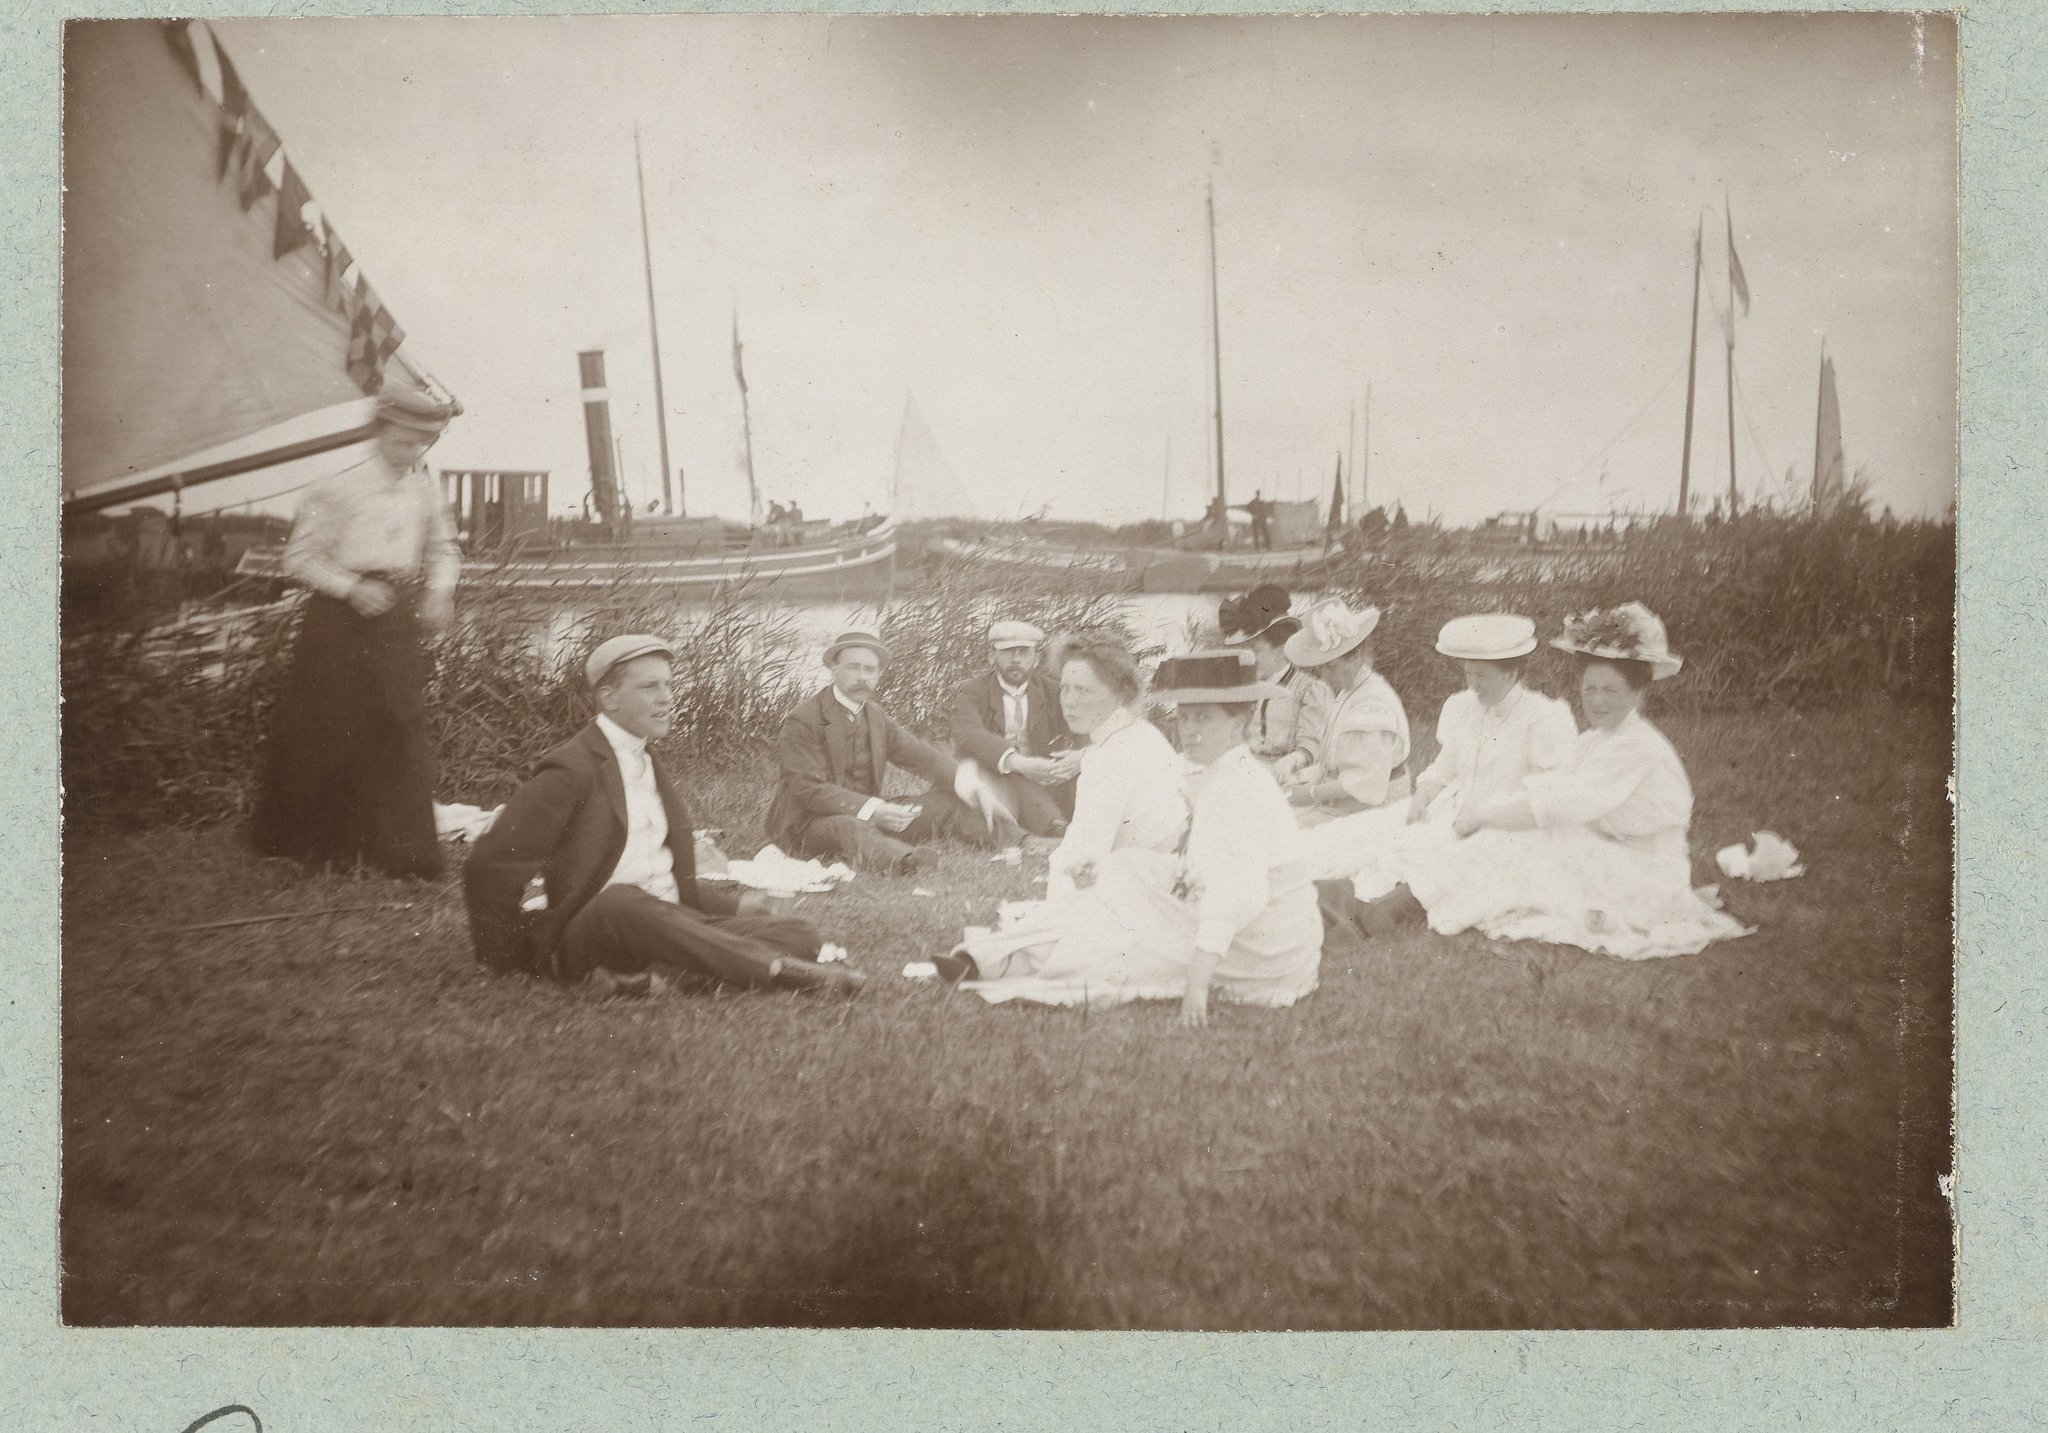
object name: photograph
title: Photographieën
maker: frits freerks fontein fz.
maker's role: fotograaf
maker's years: 1882-1928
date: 1903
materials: cardboard, paper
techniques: gelatin silver print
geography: netherlands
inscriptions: caption: ‘Pic-nic aan de oever van het Sneeker meer 1908.’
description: Op de achtergrond zijn zeil en stoomschepen zichtbaar. Foto uit album 'Photographieën".